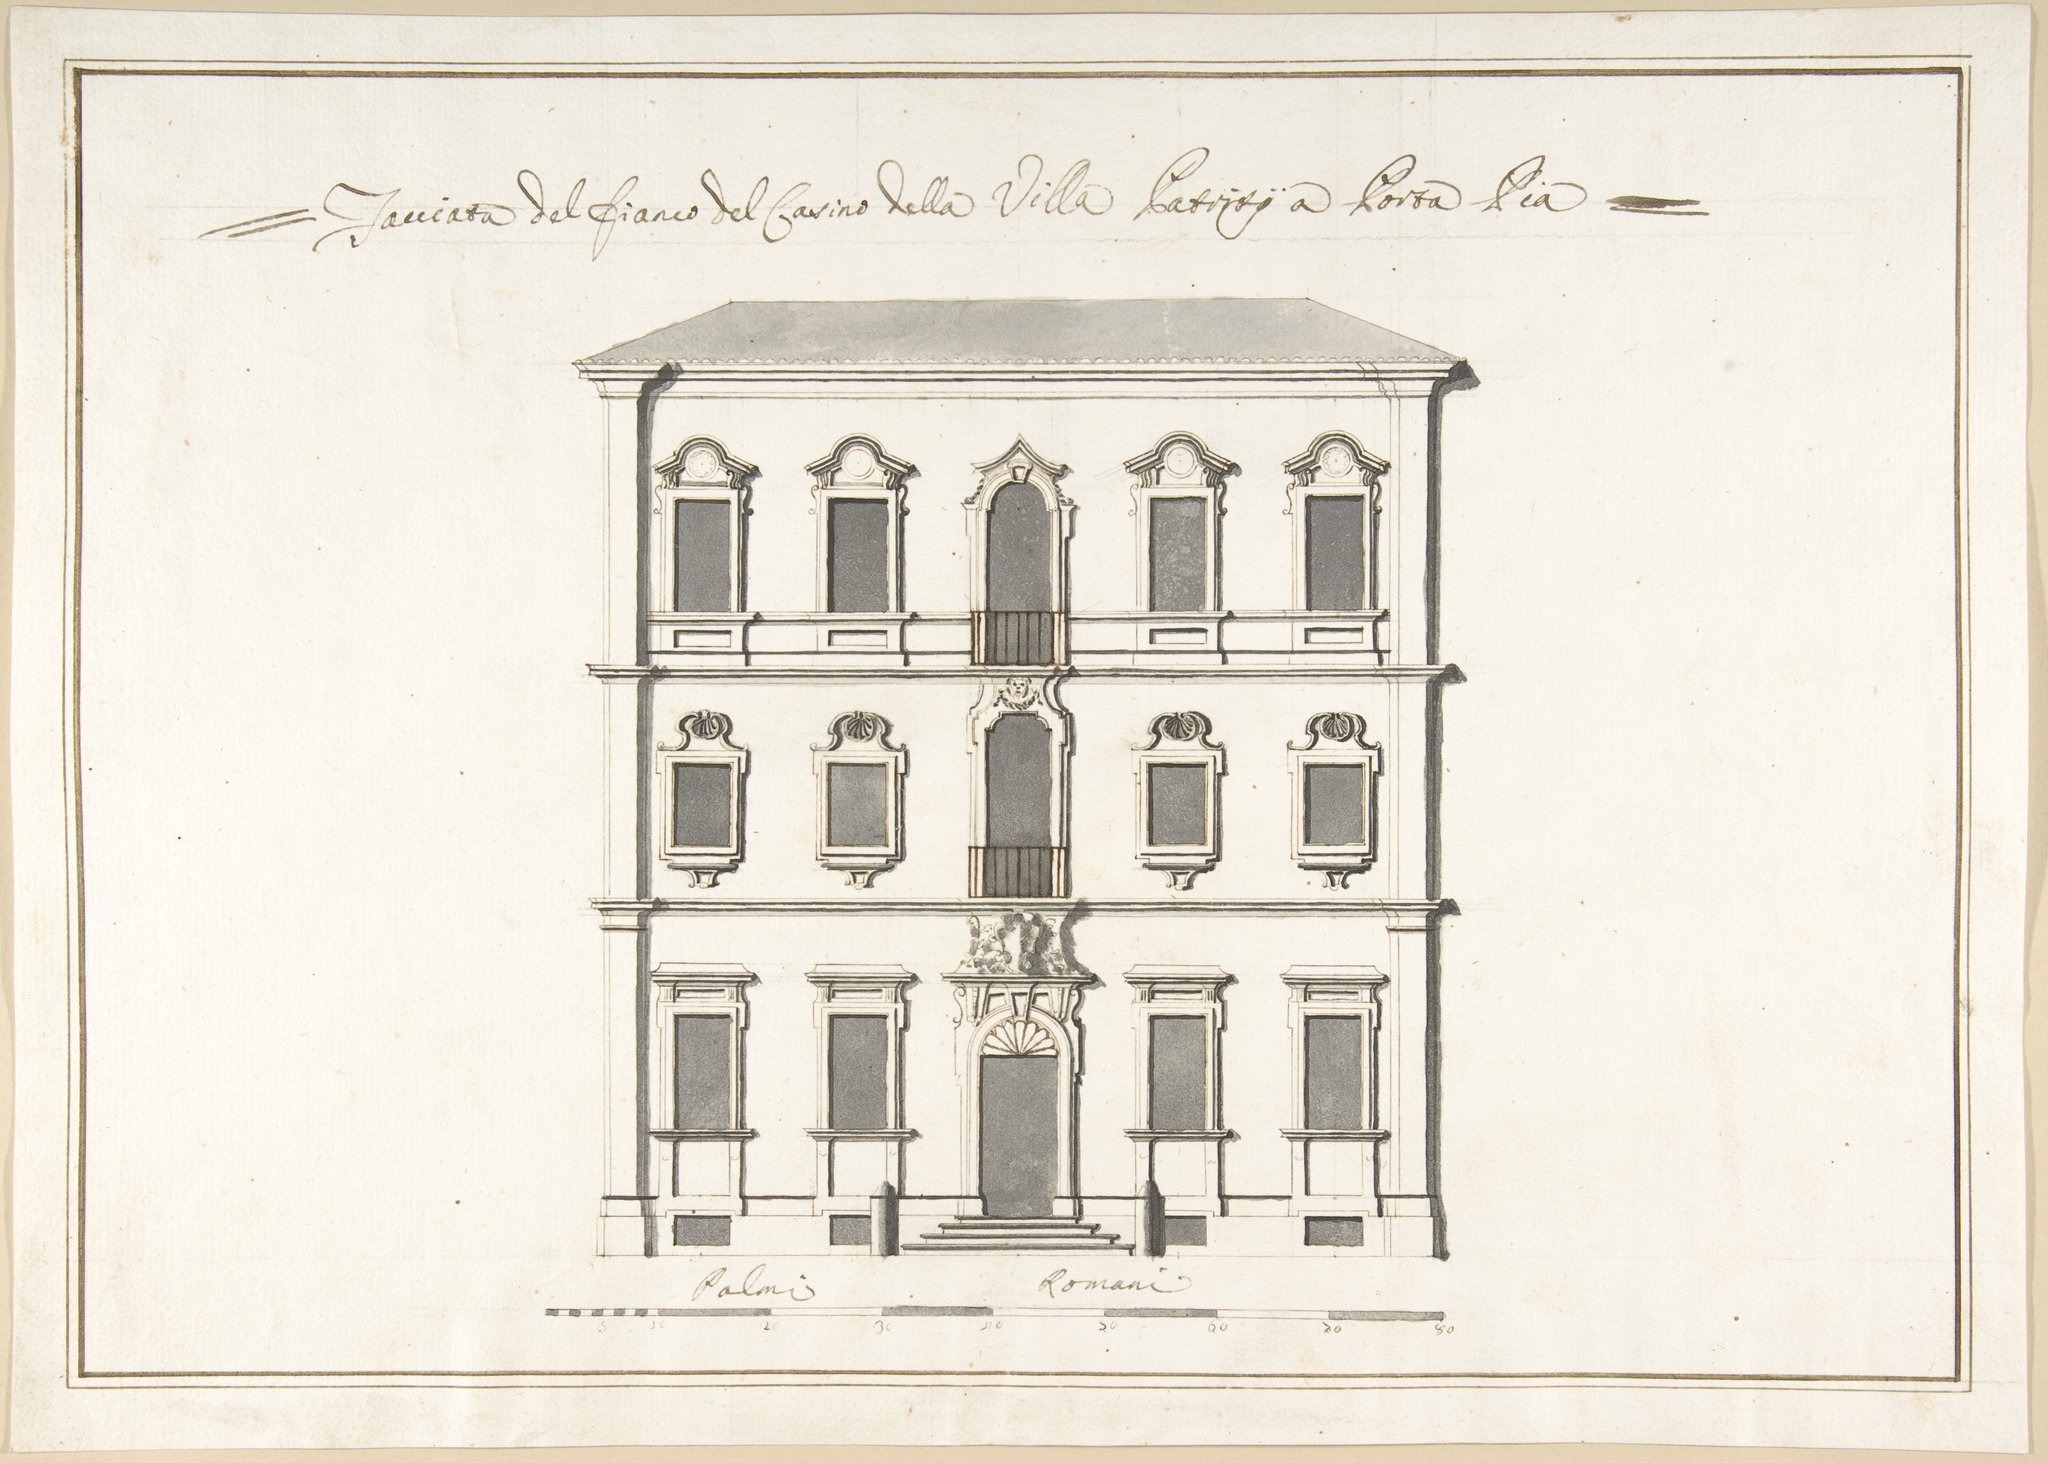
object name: drawing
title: Design of the Side Elevation for the Casino of the Villa Patritj [Patritii] at Porta Pia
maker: pietro paolo coccetti (cocchetti)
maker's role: artist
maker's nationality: italian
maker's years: 1710-1727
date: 1710-1727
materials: graphite, ink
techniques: brush, pen, wash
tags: architecture,buildings